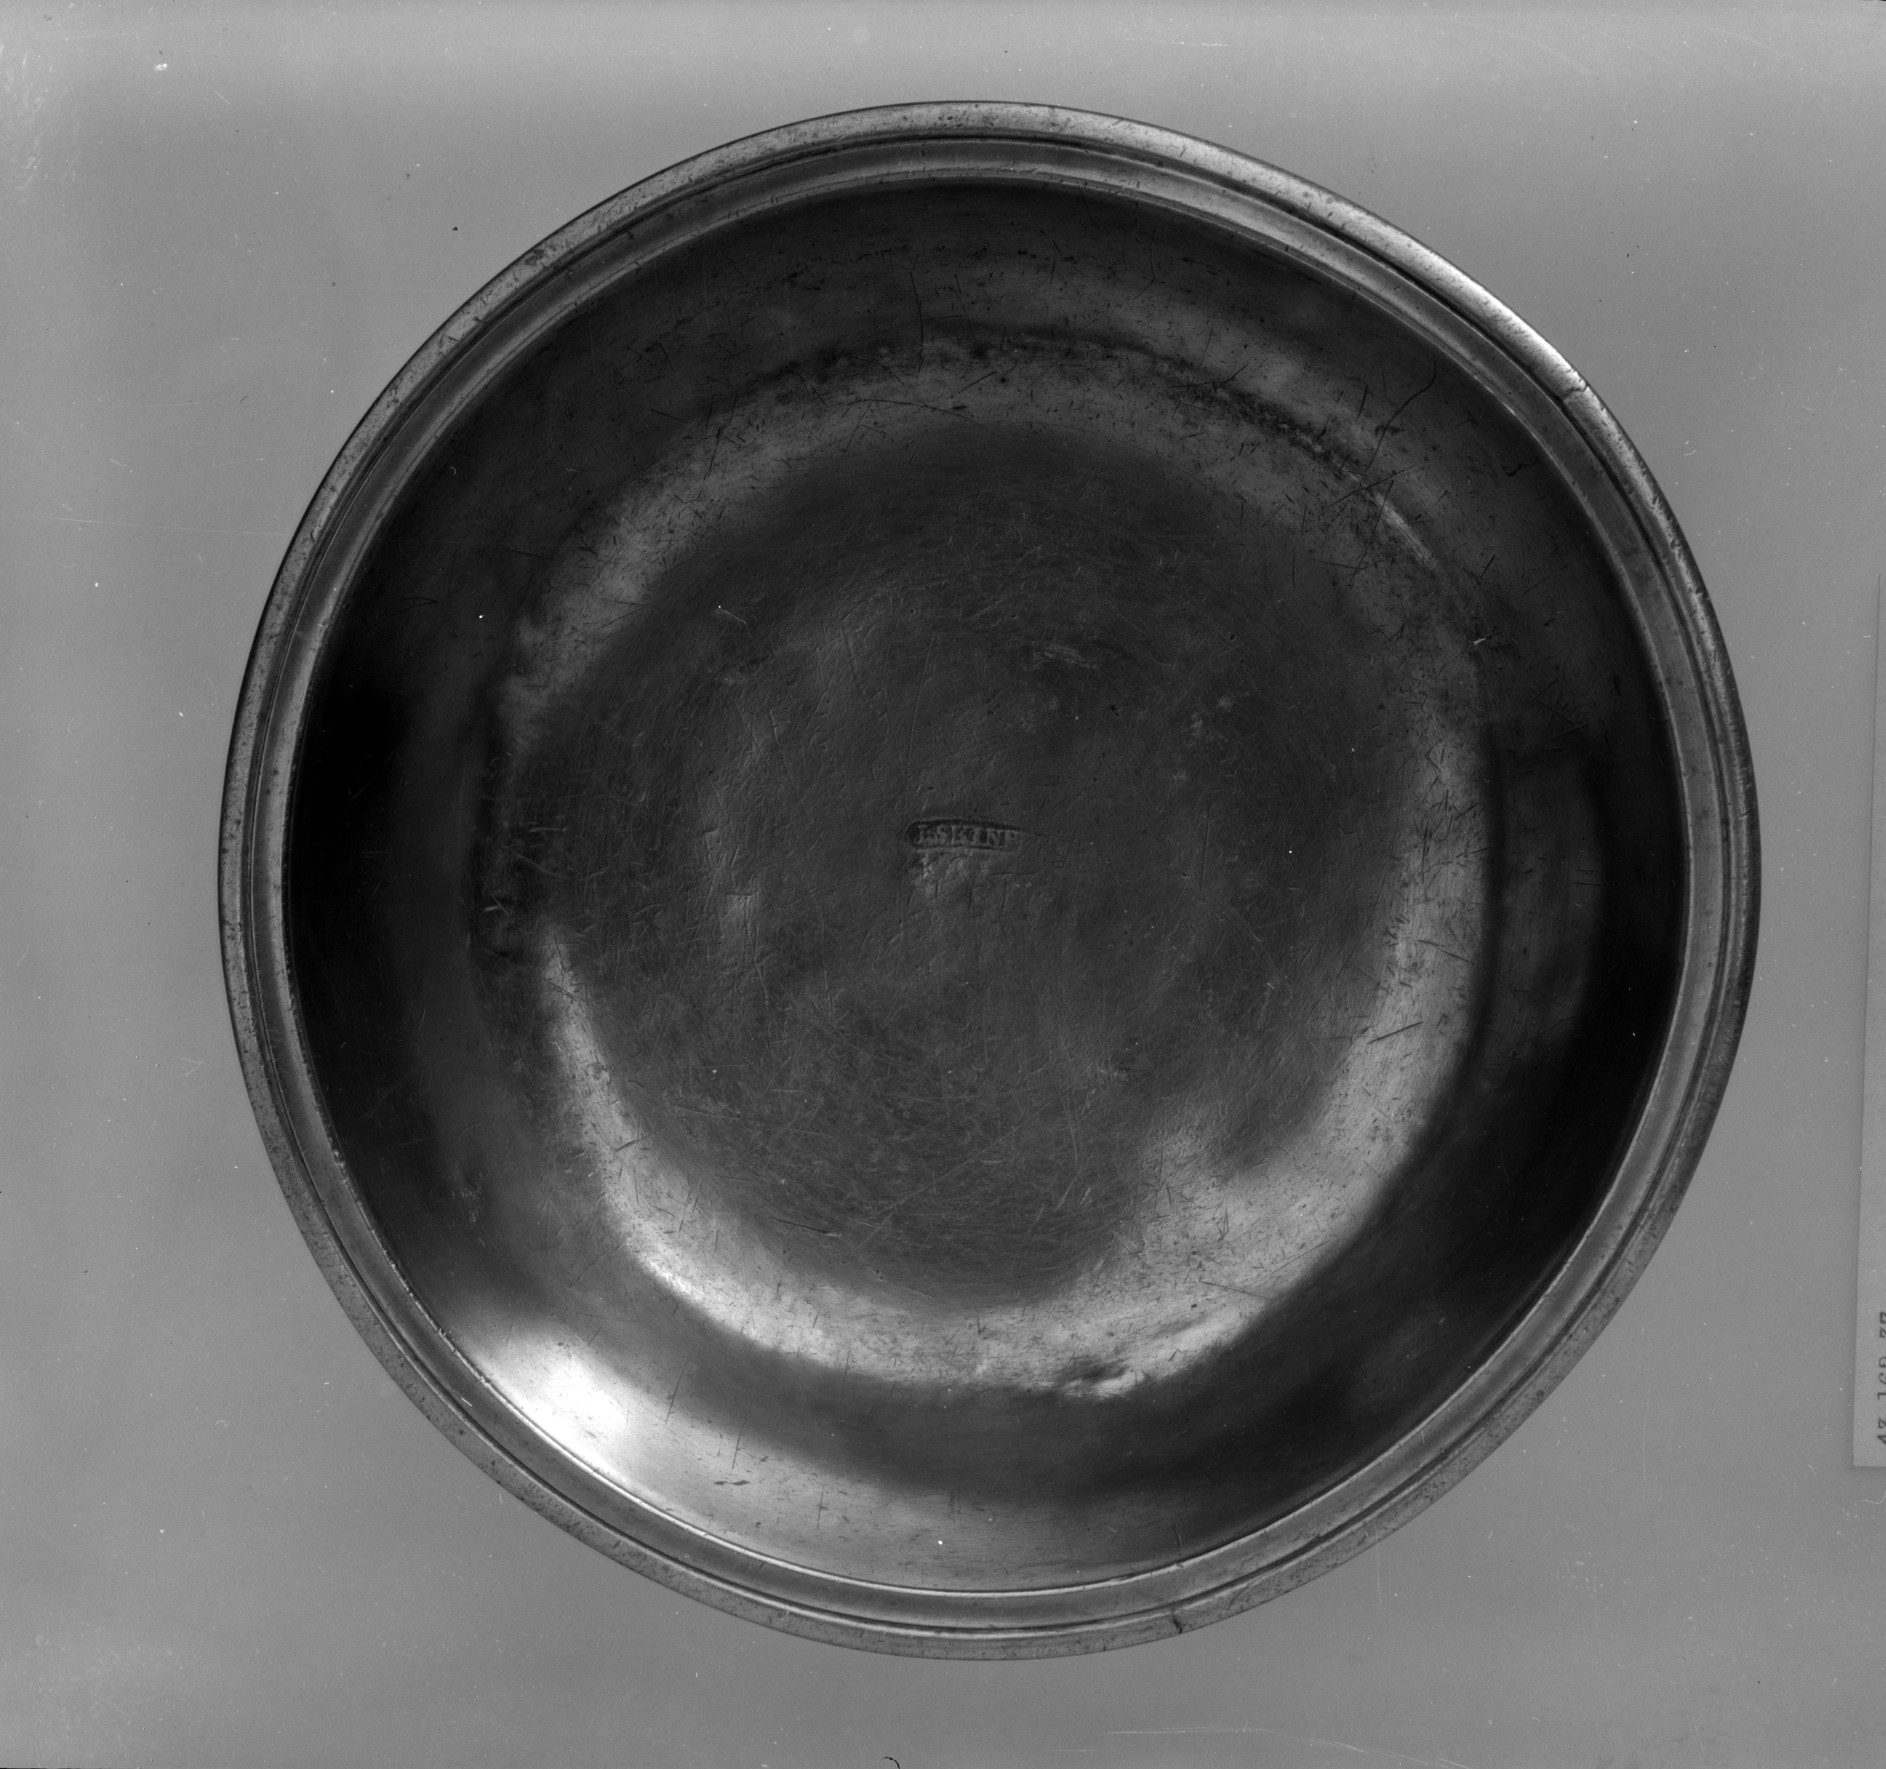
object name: basin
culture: american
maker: john skinner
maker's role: maker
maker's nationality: american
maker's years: 1733-1813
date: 1756-1785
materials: pewter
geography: united states